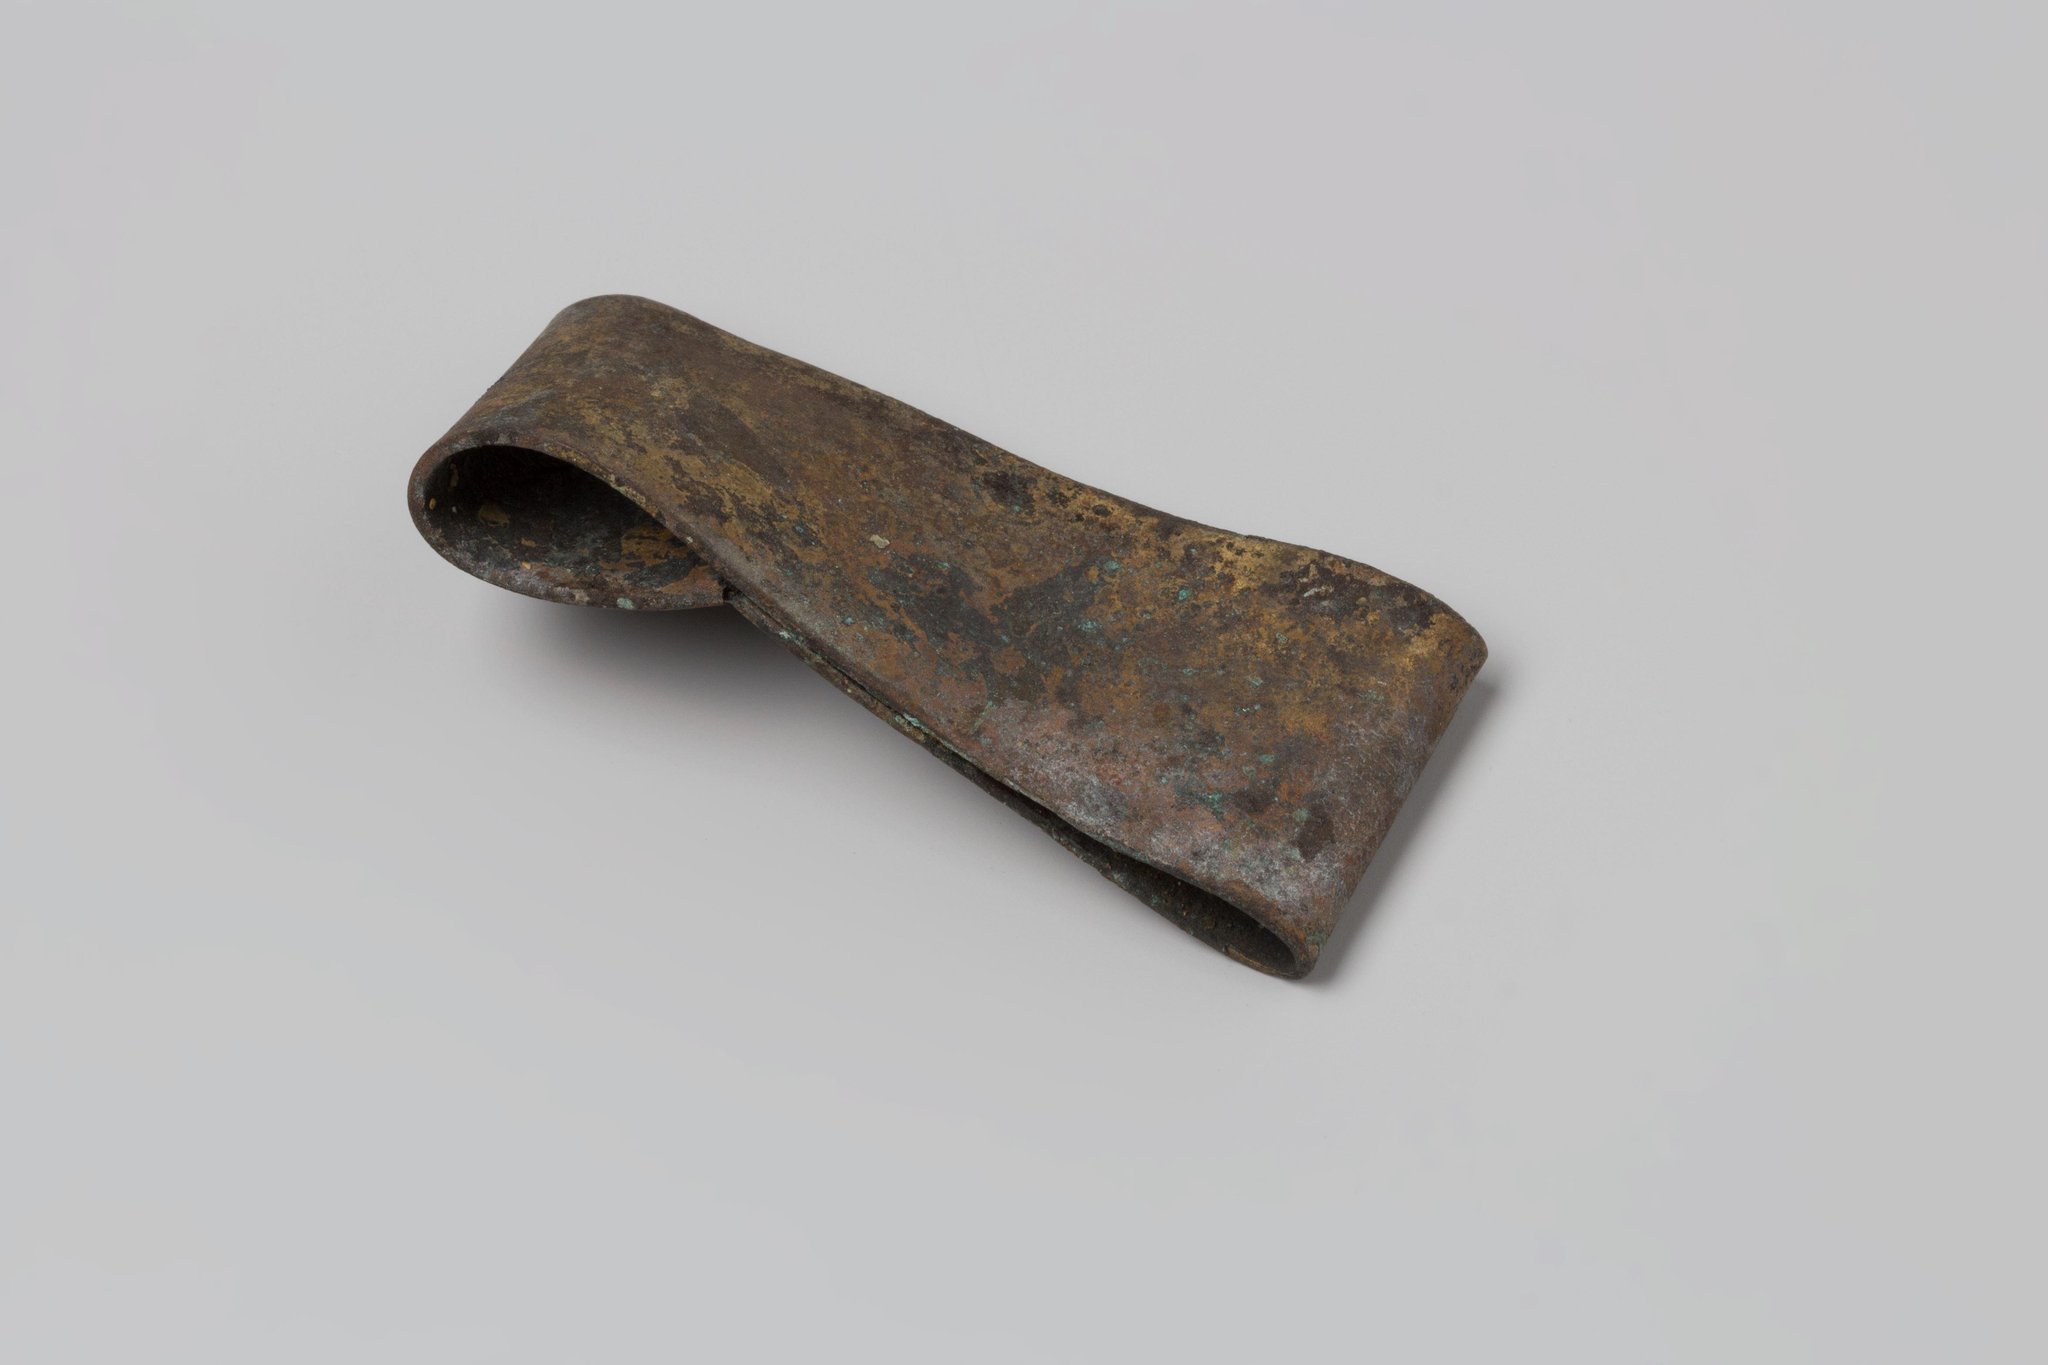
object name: firehose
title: Fragment van brandslangringen uit het wrak van de Oost-Indiëvaarder Hollandia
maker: Anonymous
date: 1700-1743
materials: copper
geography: netherlands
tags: verenigde oostindische compagnie, hollandia (schip), annet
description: Fire engine, firehose; fragments, id. NG-1975-20-H-1271-a, squashed.